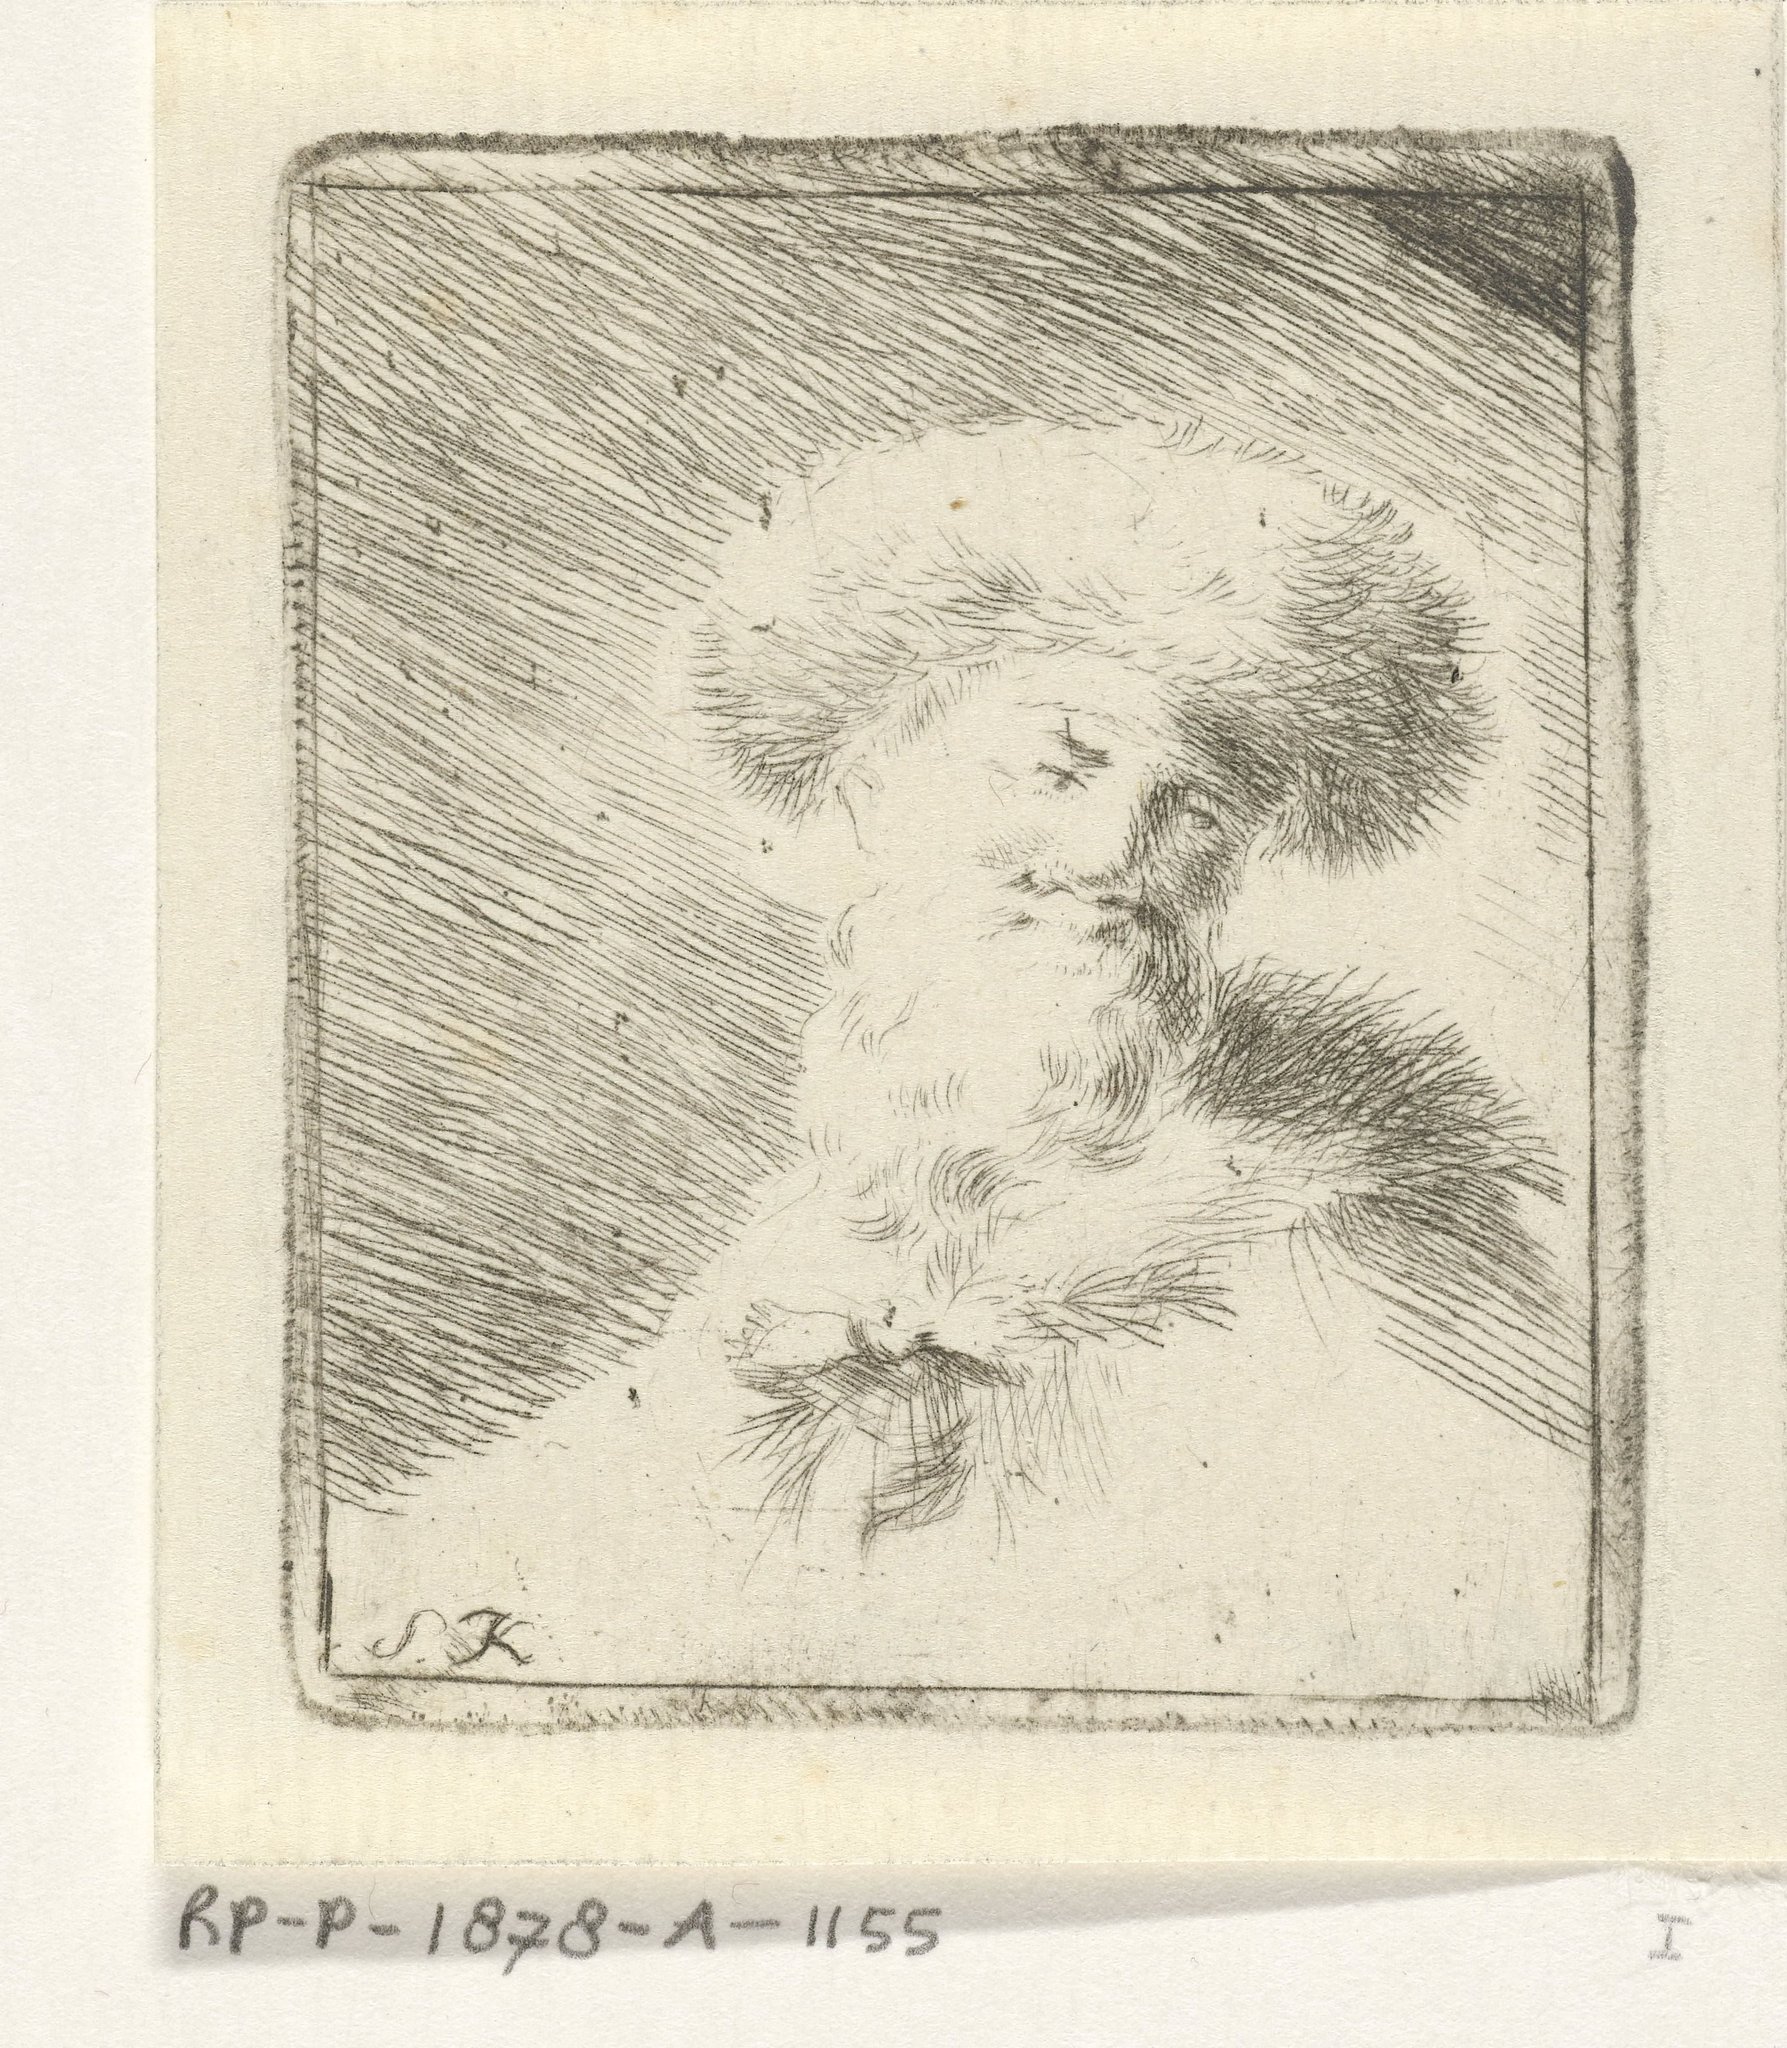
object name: print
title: Portret van een onbekende man met bontmuts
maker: simon klapmuts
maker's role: print maker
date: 1744-1780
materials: paper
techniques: etching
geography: moordrecht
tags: head-gear: cap (+ men's clothes), old man, fashion, clothing (+ fur used for clothes)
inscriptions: collector's mark: Lugt 2227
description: Portretbuste van een onbekende man met een bontmuts op het hoofd en een bontkraag.